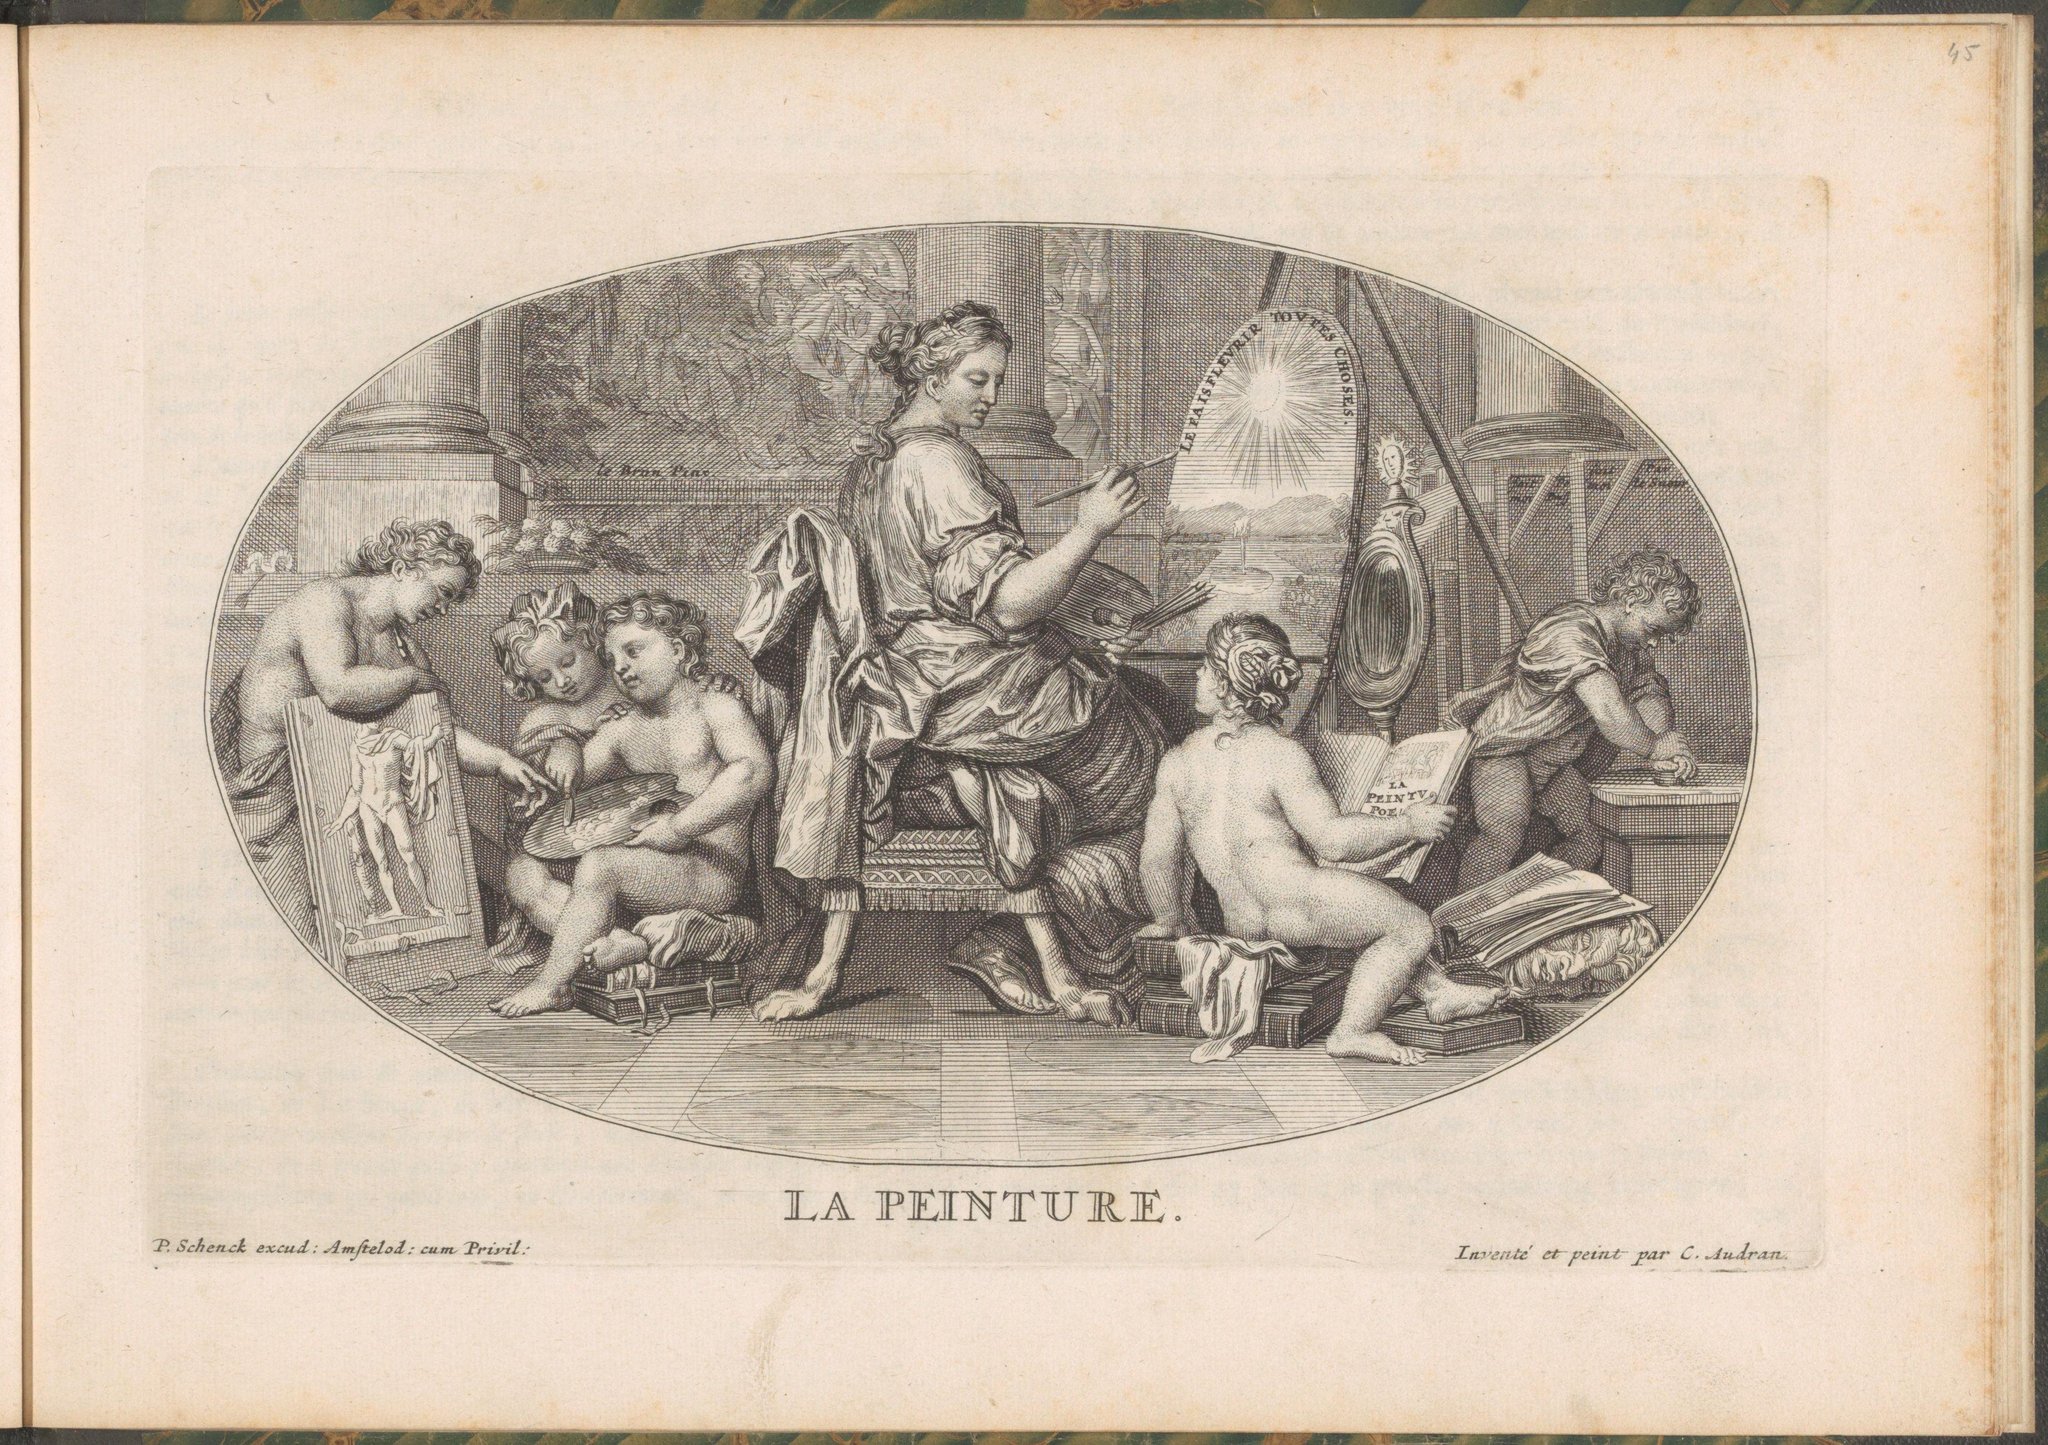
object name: print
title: Le Cabinet des Beaux Arts (...) / De Schatkamer der Vrye Konsten (...)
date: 1693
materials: paper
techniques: engraving, etching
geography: amsterdam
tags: 'pictura', symbolic representations, allegories and emblems ~ painting; 'pittura' (ripa), (decorated) ceiling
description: Plafondstuk met de personificatie van Schilderkunst. Zij houdt penseel en schilderspalet in haar handen en werkt aan een schilderij. Putti assisteren haar. Geheel rechts wrijft een putto verf. Prent maakt deel uit van een album.